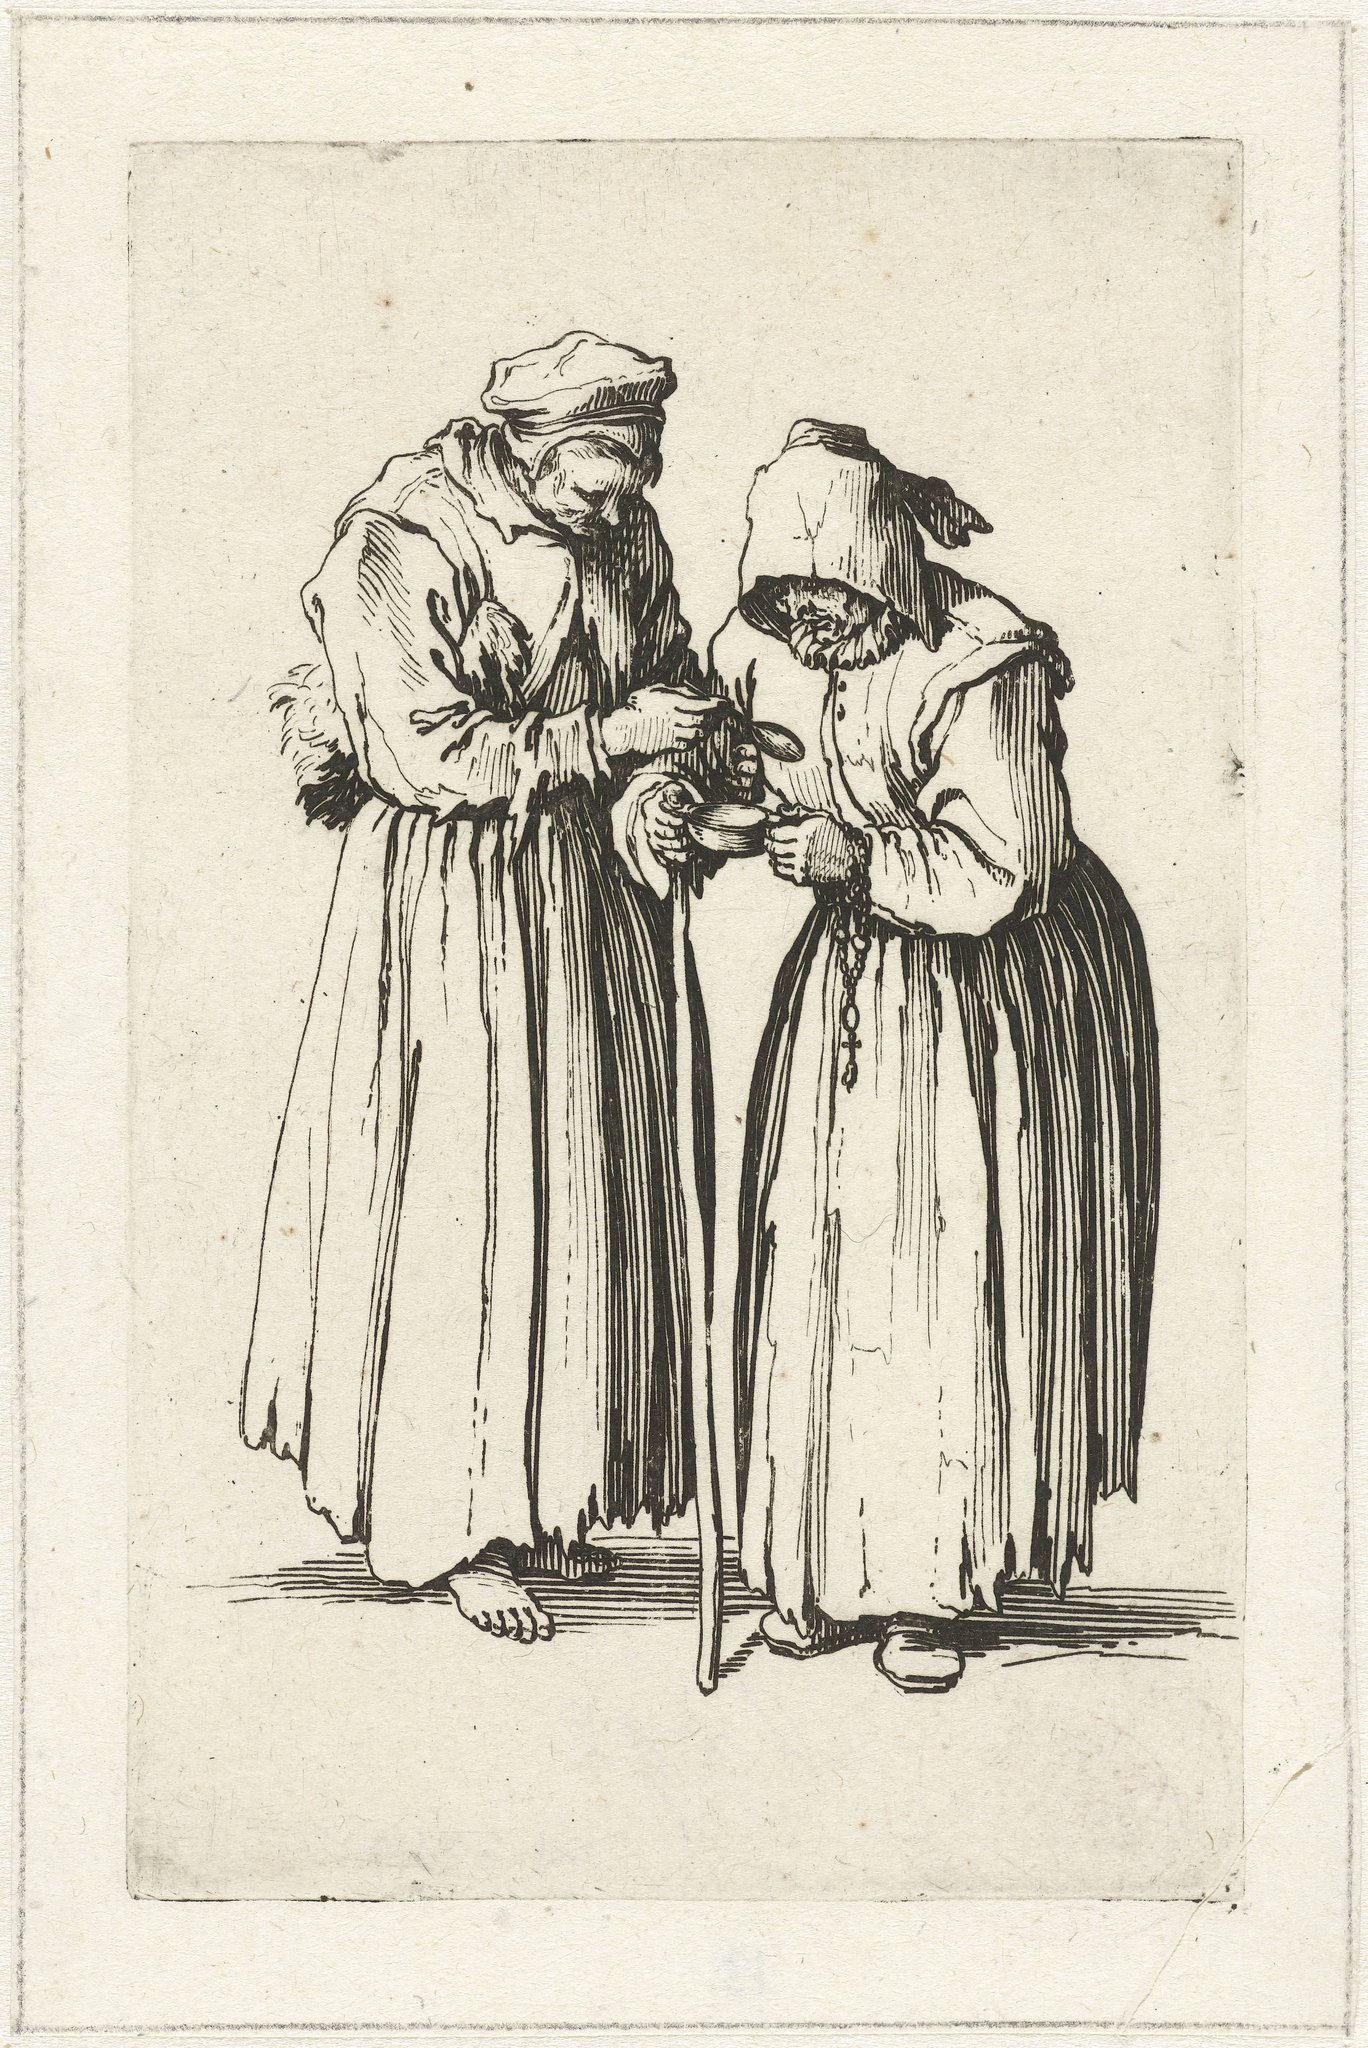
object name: print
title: Les Gueux / Les Mendiants / Les Baroni / Les Barons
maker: jacques callot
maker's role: draughtsman, print maker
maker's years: 1592-1635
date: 1622-1623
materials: paper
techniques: etching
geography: nancy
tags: muff, aids for prayer, e.g. rosary, walking-stick, staff, spoon, begging bowl, beggar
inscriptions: collector's mark: Lugt 240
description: Twee vrouwen, gekleed in lompen, de linker met een lepel in de hand en een mof onder de arm, de rechter met een bedelnap en een stok in de handen en een rozenkrans om de pols. Deze prent is onderdeel van een serie van 25 prenten met bedelaars en zwervers, zoals Callot die waarschijnlijk in Italië heeft gezien.